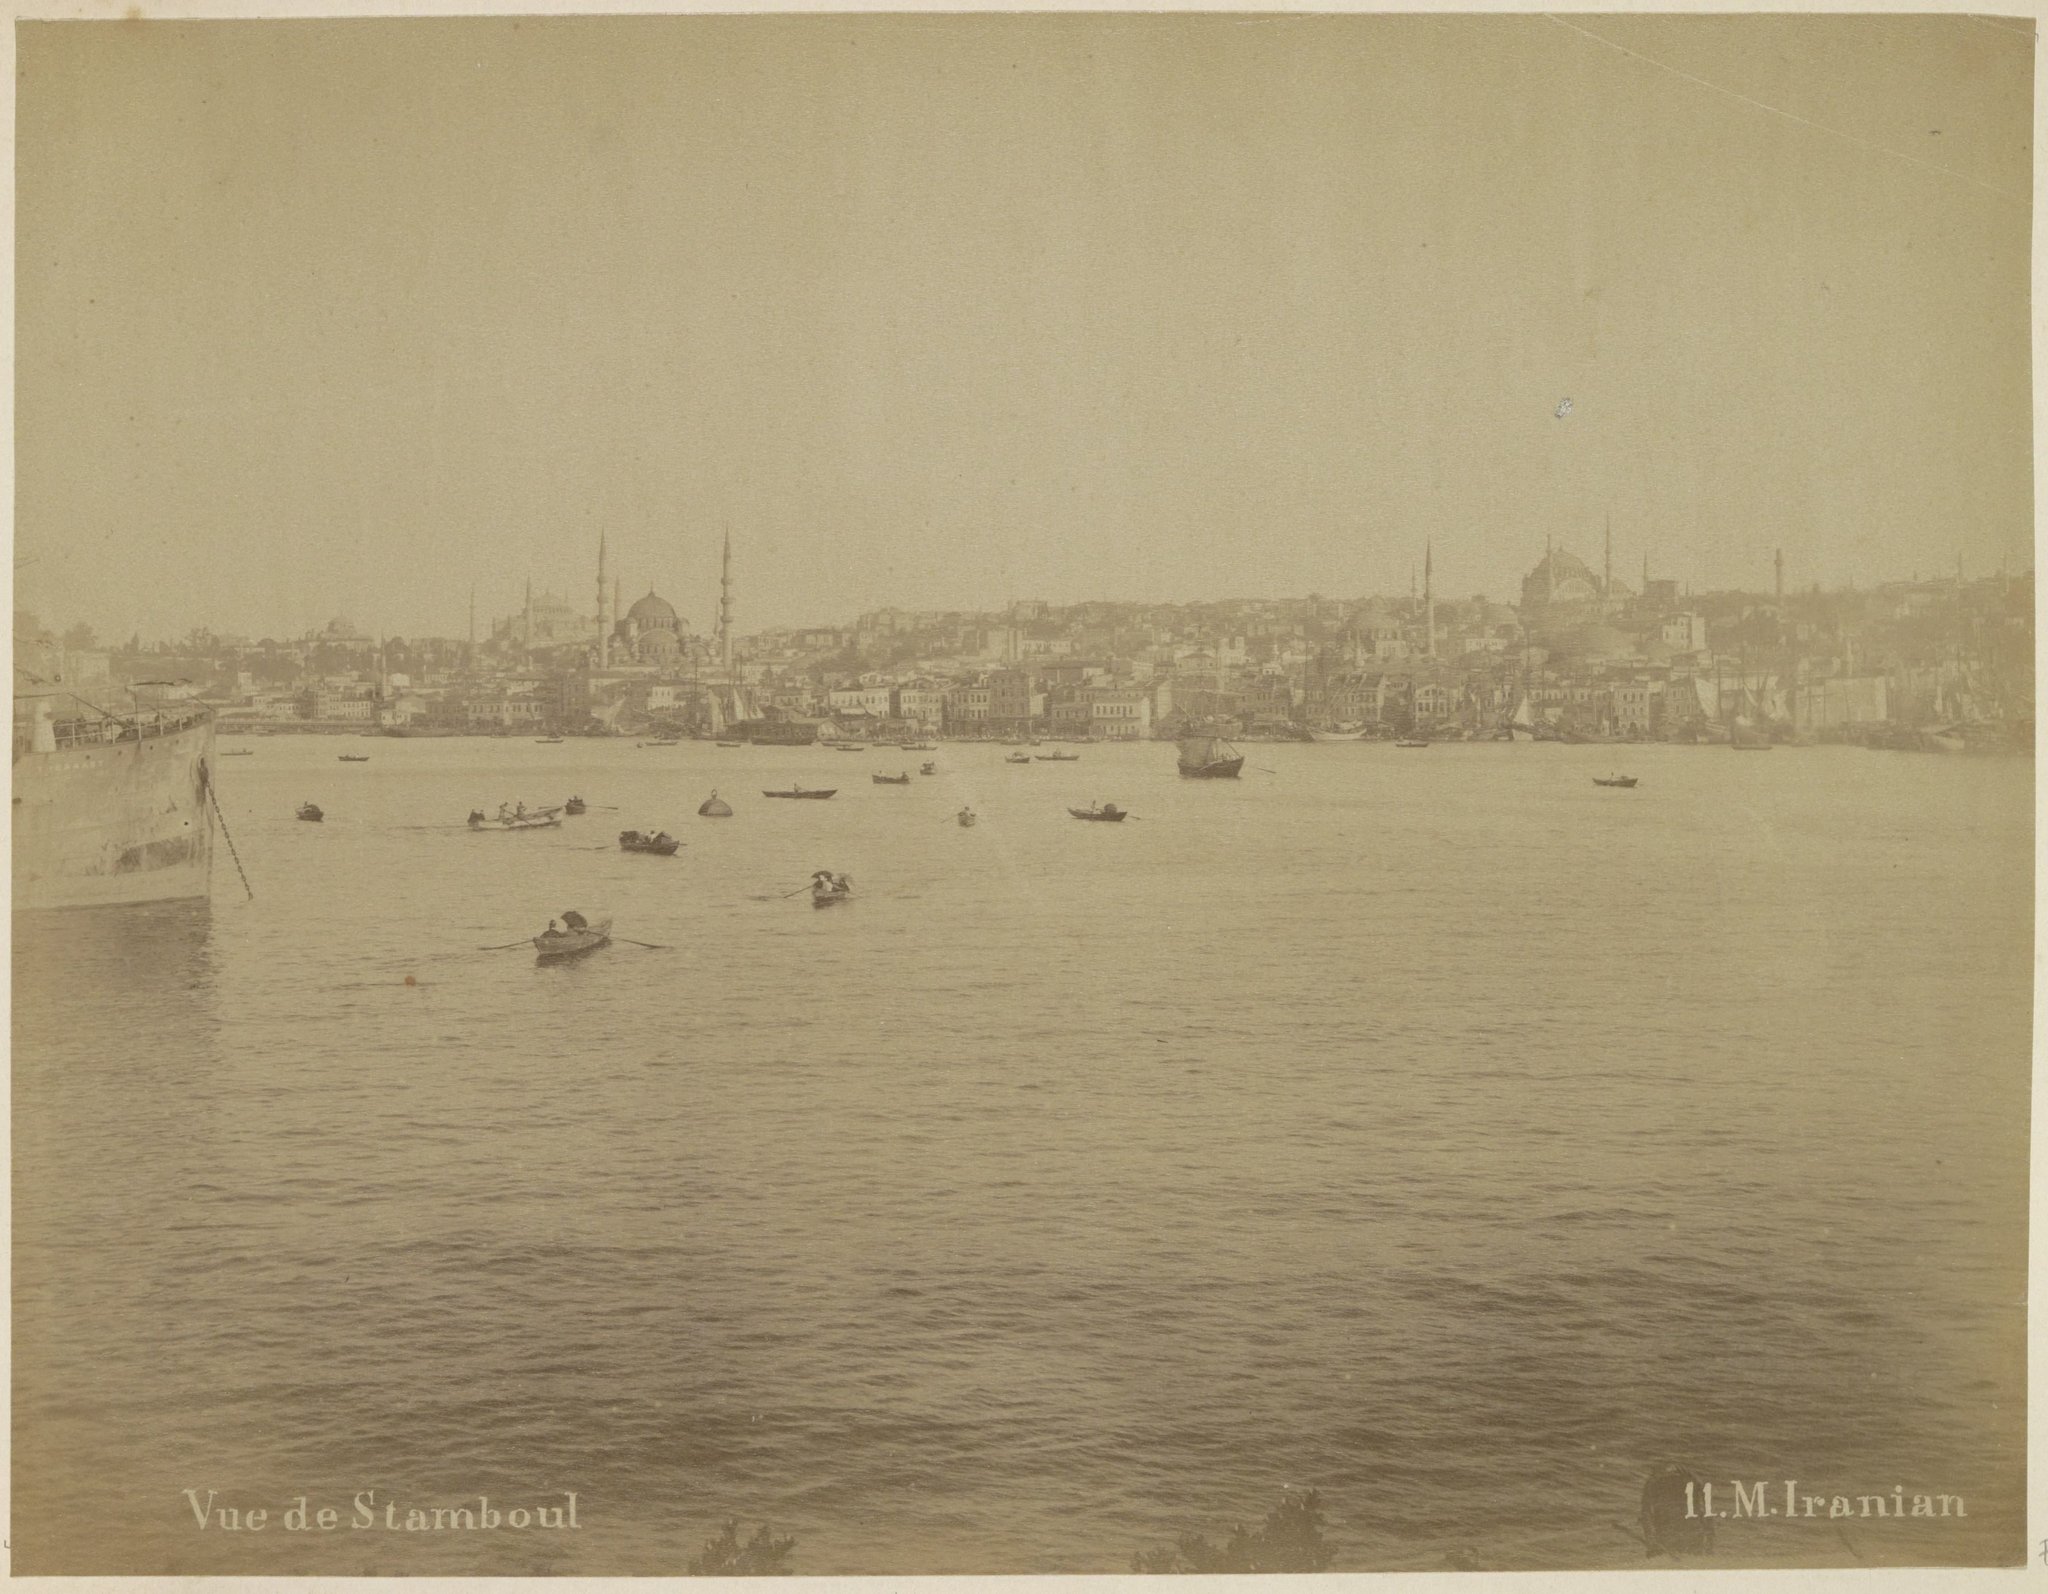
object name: photograph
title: Gezicht op Istanbul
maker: mihran iranian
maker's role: fotograaf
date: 1880-1890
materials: paper, photographic support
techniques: albumen print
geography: istanbul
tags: temple, shrine ~ islam, mohammedanism, prospect of city, town panorama, silhouette of city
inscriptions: negative number: ‘11’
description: Onderdeel van Reisalbum met foto's van bezienswaardigheden in Frankrijk, Griekenland en Turkije.